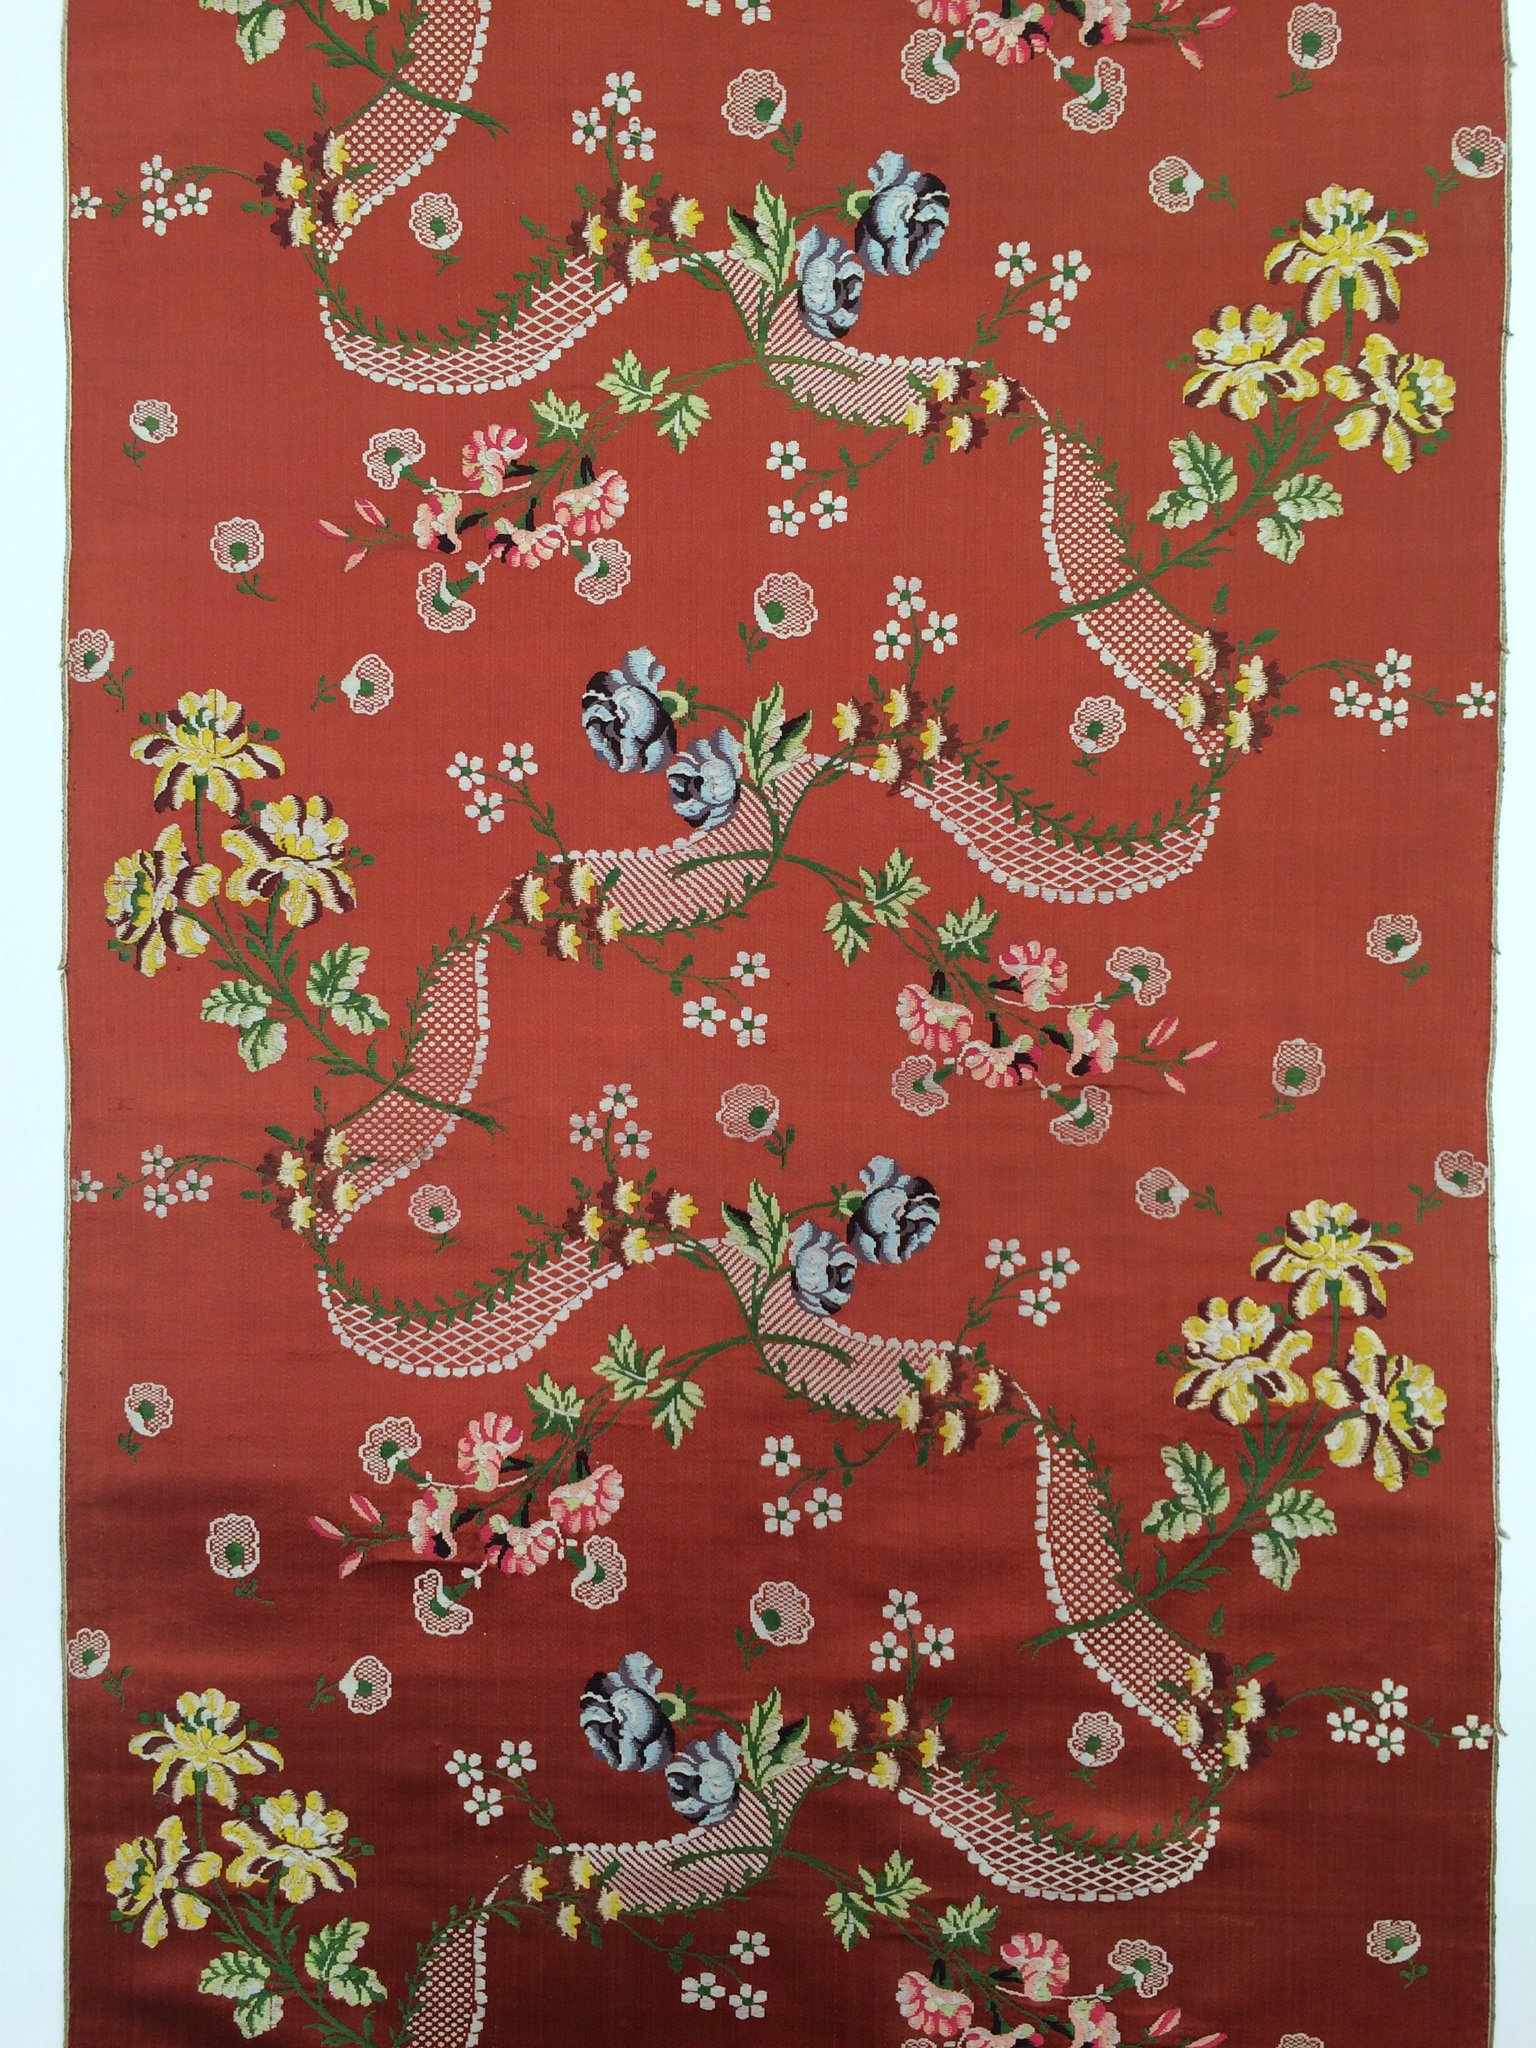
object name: panel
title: Dress panels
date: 1775-1778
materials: silk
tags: flowers